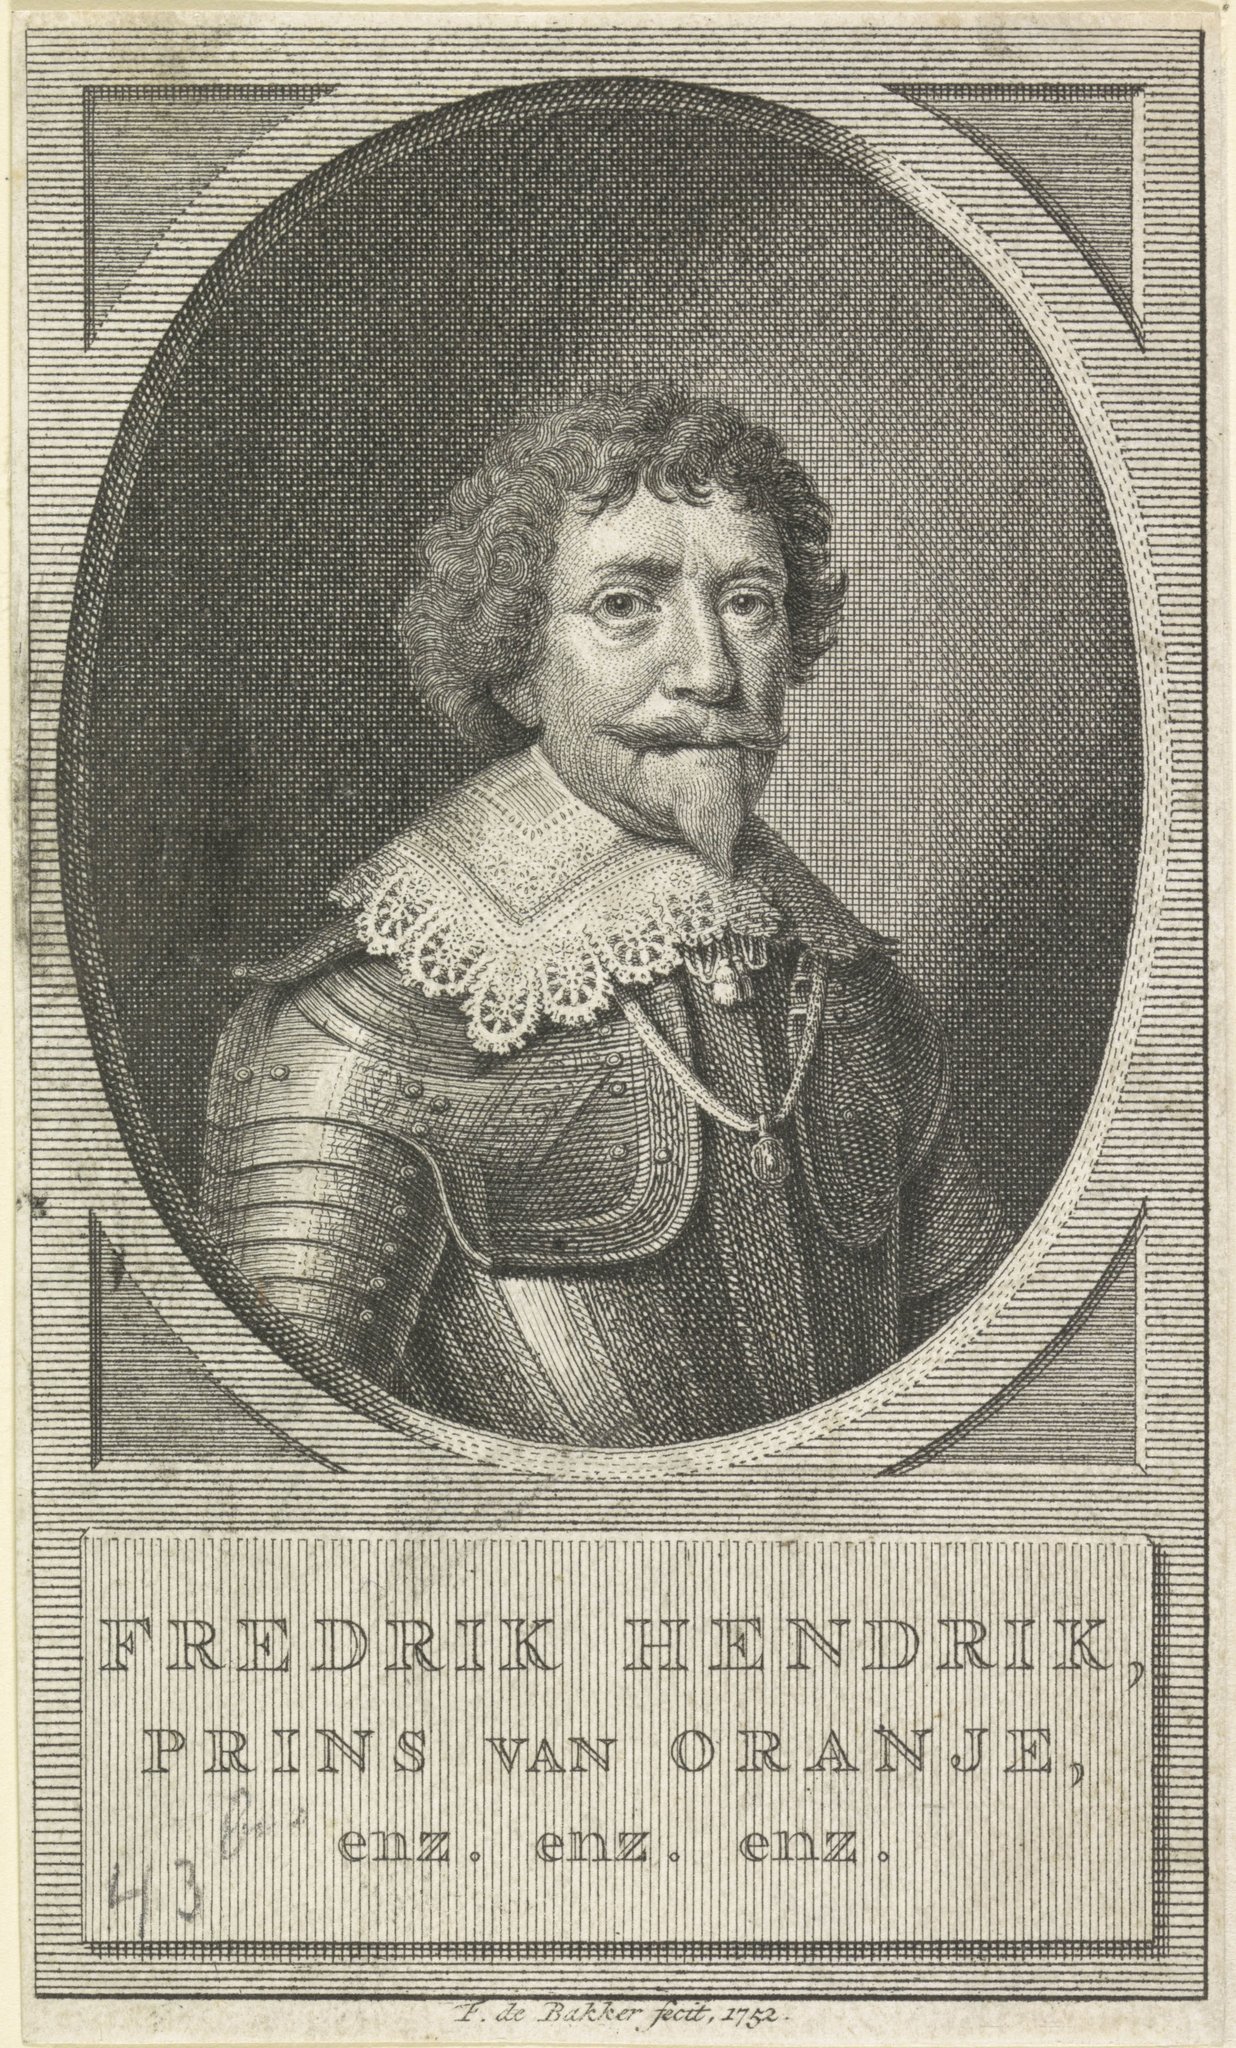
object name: print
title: Portret van Frederik Hendrik, prins van Oranje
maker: frans de bakker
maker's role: print maker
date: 1752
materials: paper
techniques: engraving, etching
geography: amsterdam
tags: delft, the hague, frederick henry (prince of orange), knighthood order (garter) - insignia of a knighthood order, e.g.: badge, chain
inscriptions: collector's mark: Lugt 2228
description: De hier vermelde titel verwijst naar de hoogst verkregen titel van de geportretteerde, niet per se naar de titel die de geportretteerde op deze voorstelling draagt.